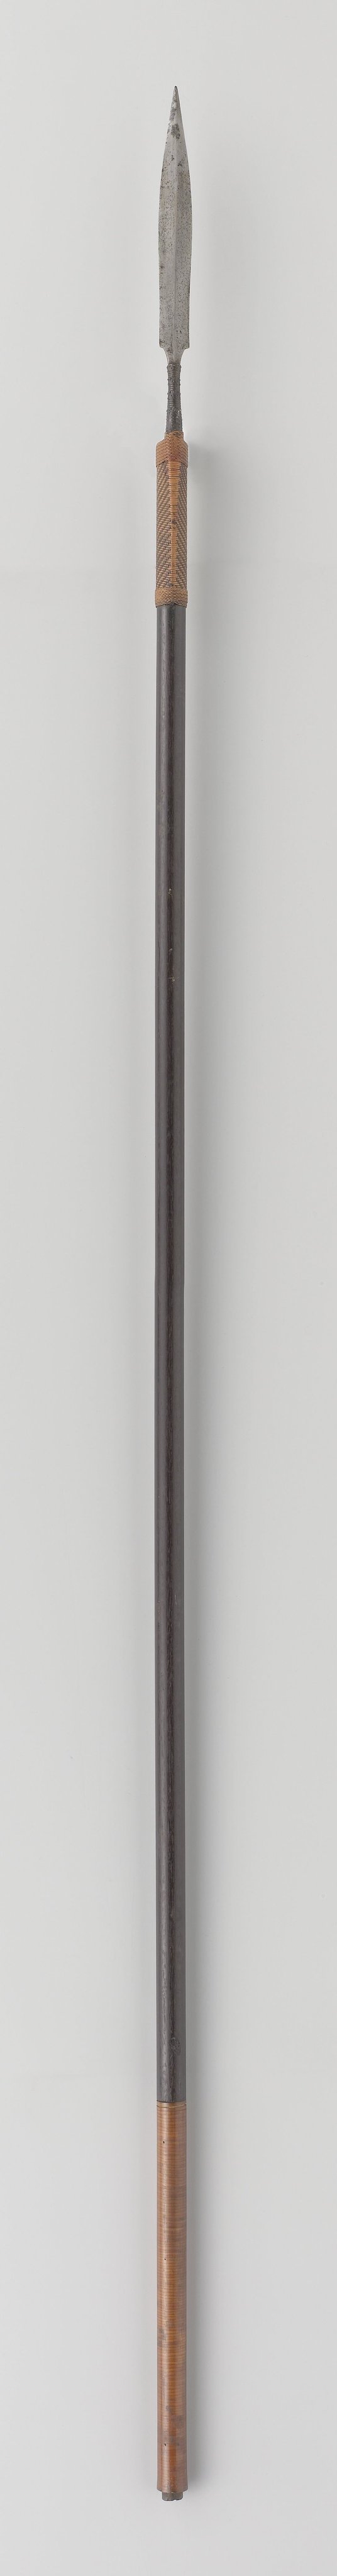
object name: pike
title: Lans uit het wapenrek van Gouverneur-Generaal J.C. baron Baud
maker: Anonymous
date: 1800-1900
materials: iron, paint, wood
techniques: braiding, cutting, forging, painting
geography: kalimantan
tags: the hague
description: Holle zwartgeverfde houten schacht, waarop smalle kling uitlopend in een scherpe punt. De kling is met fijngevlochten riet aan de schacht bevestigd. De basis van de kling heeft kleine puntvormige uitsteeksels. Onderaan de schacht zit een handvat van gevernist riet.